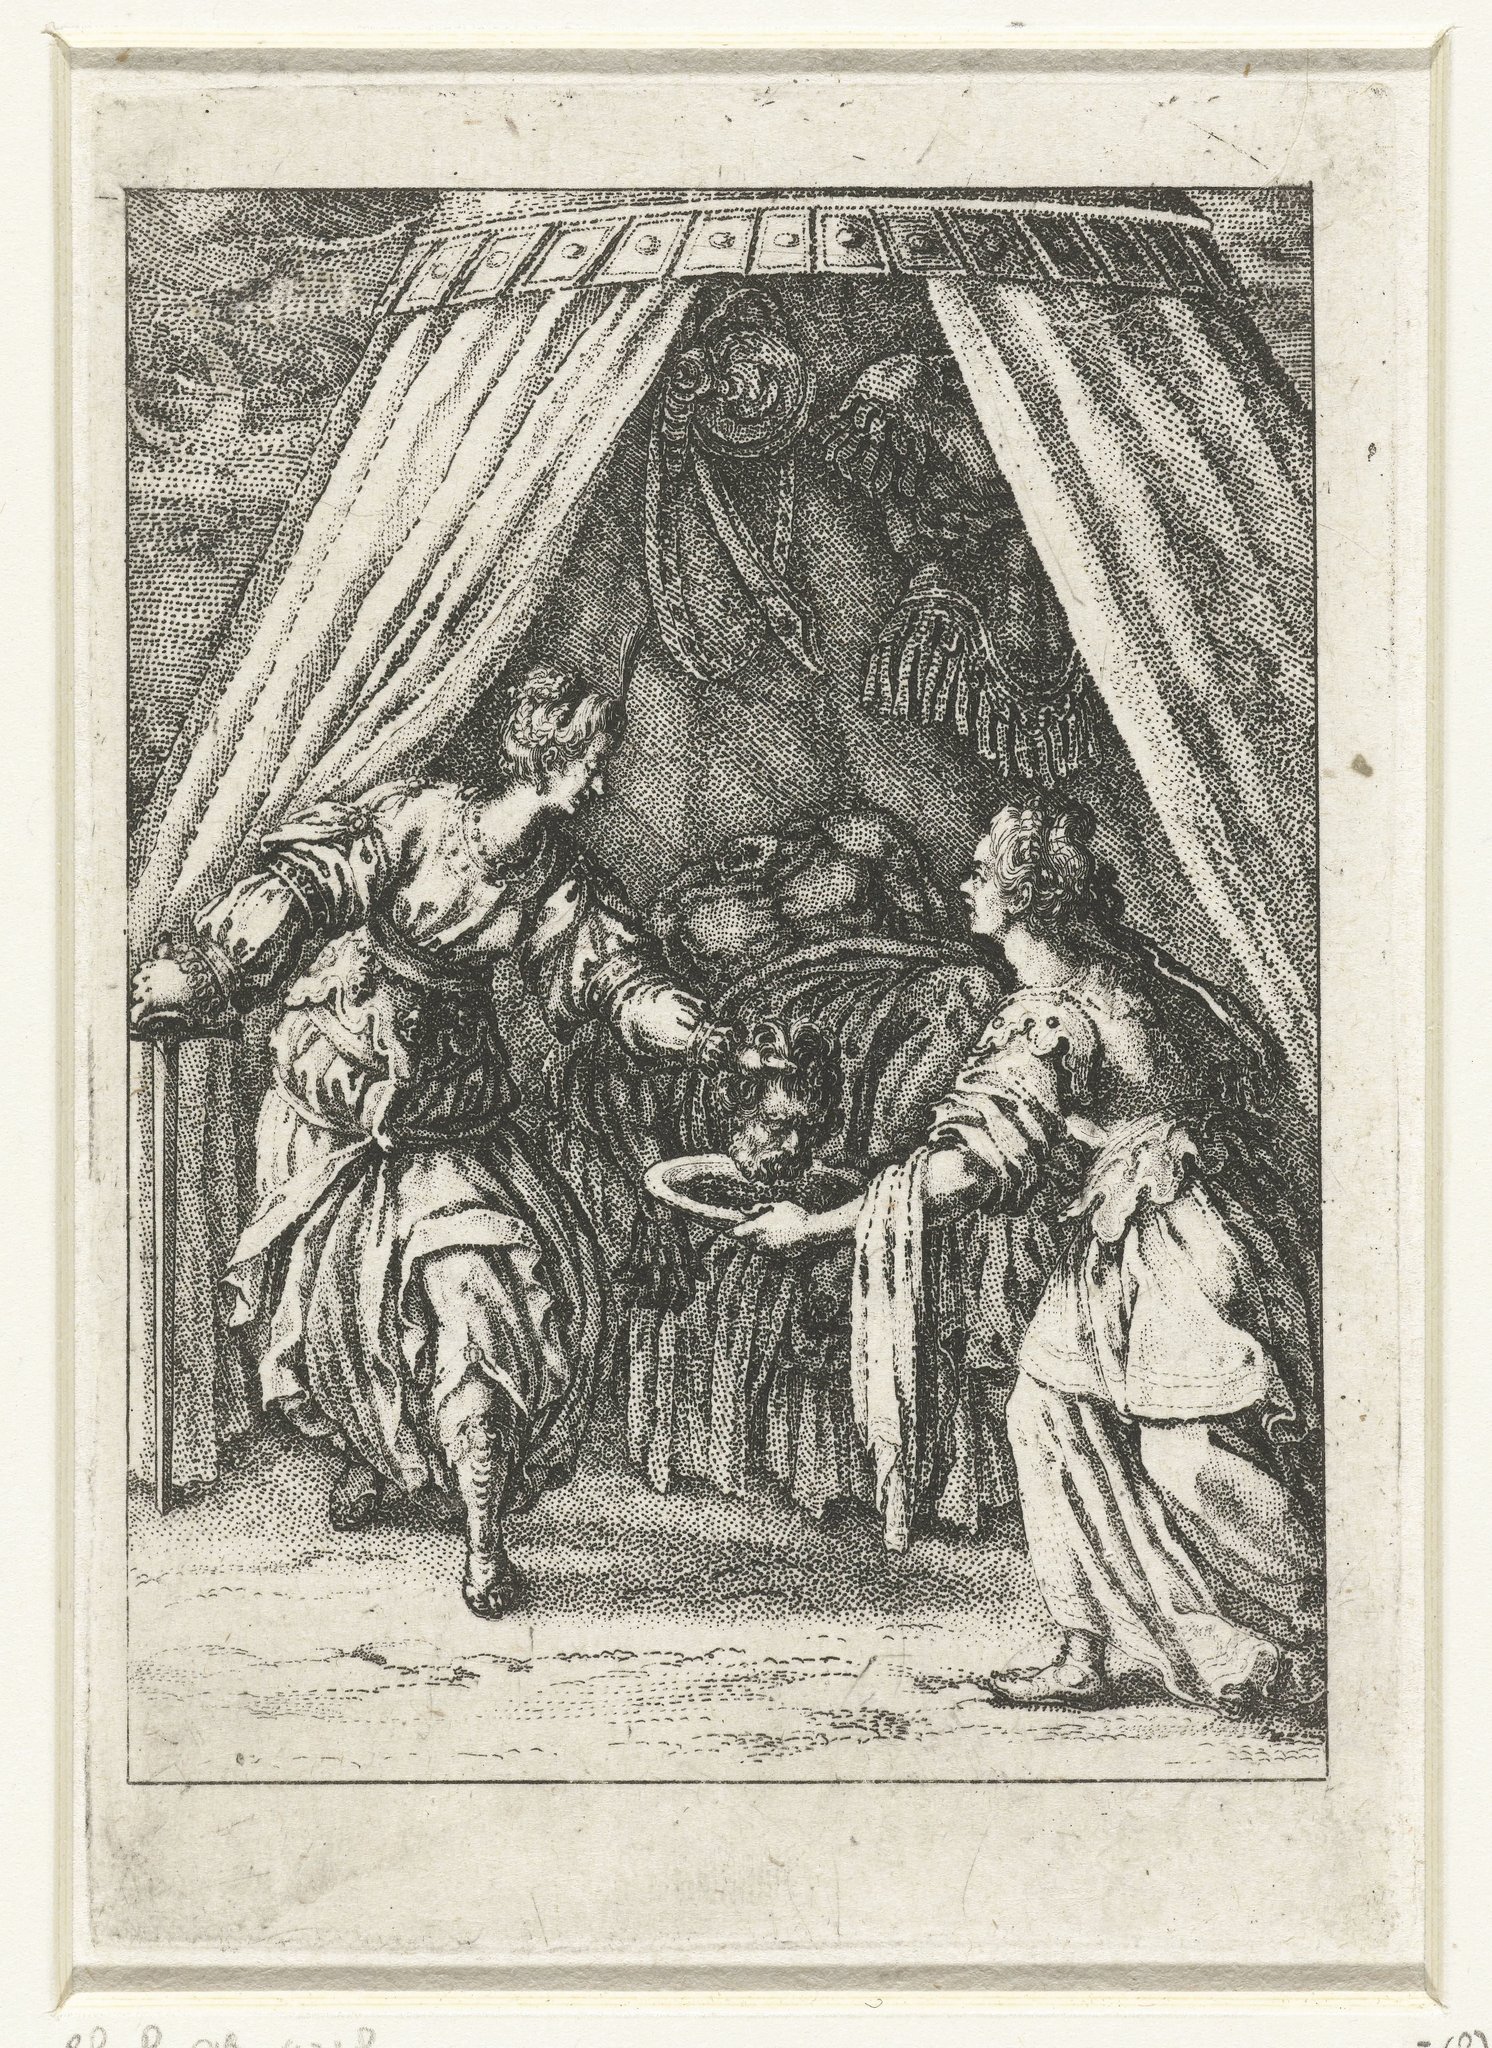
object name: print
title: Judith met het hoofd van Holofernes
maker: jacques callot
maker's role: draughtsman, print maker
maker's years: 1592-1635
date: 1621-1635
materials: paper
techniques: etching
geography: nancy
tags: holofernes' head is put on a dish, and covered with a cloth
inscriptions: collector's mark: Lugt 240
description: Judith legt het hoofd van Holofernes, dat ze zojuist met een zwaard afgehakt heeft, op een schaal die haar dienstmaagd voor haar ophoudt. Het ontzielde lichaam van Holofernes ligt achter haar in bed in een legertent. Onder de voorstelling een lege marge.